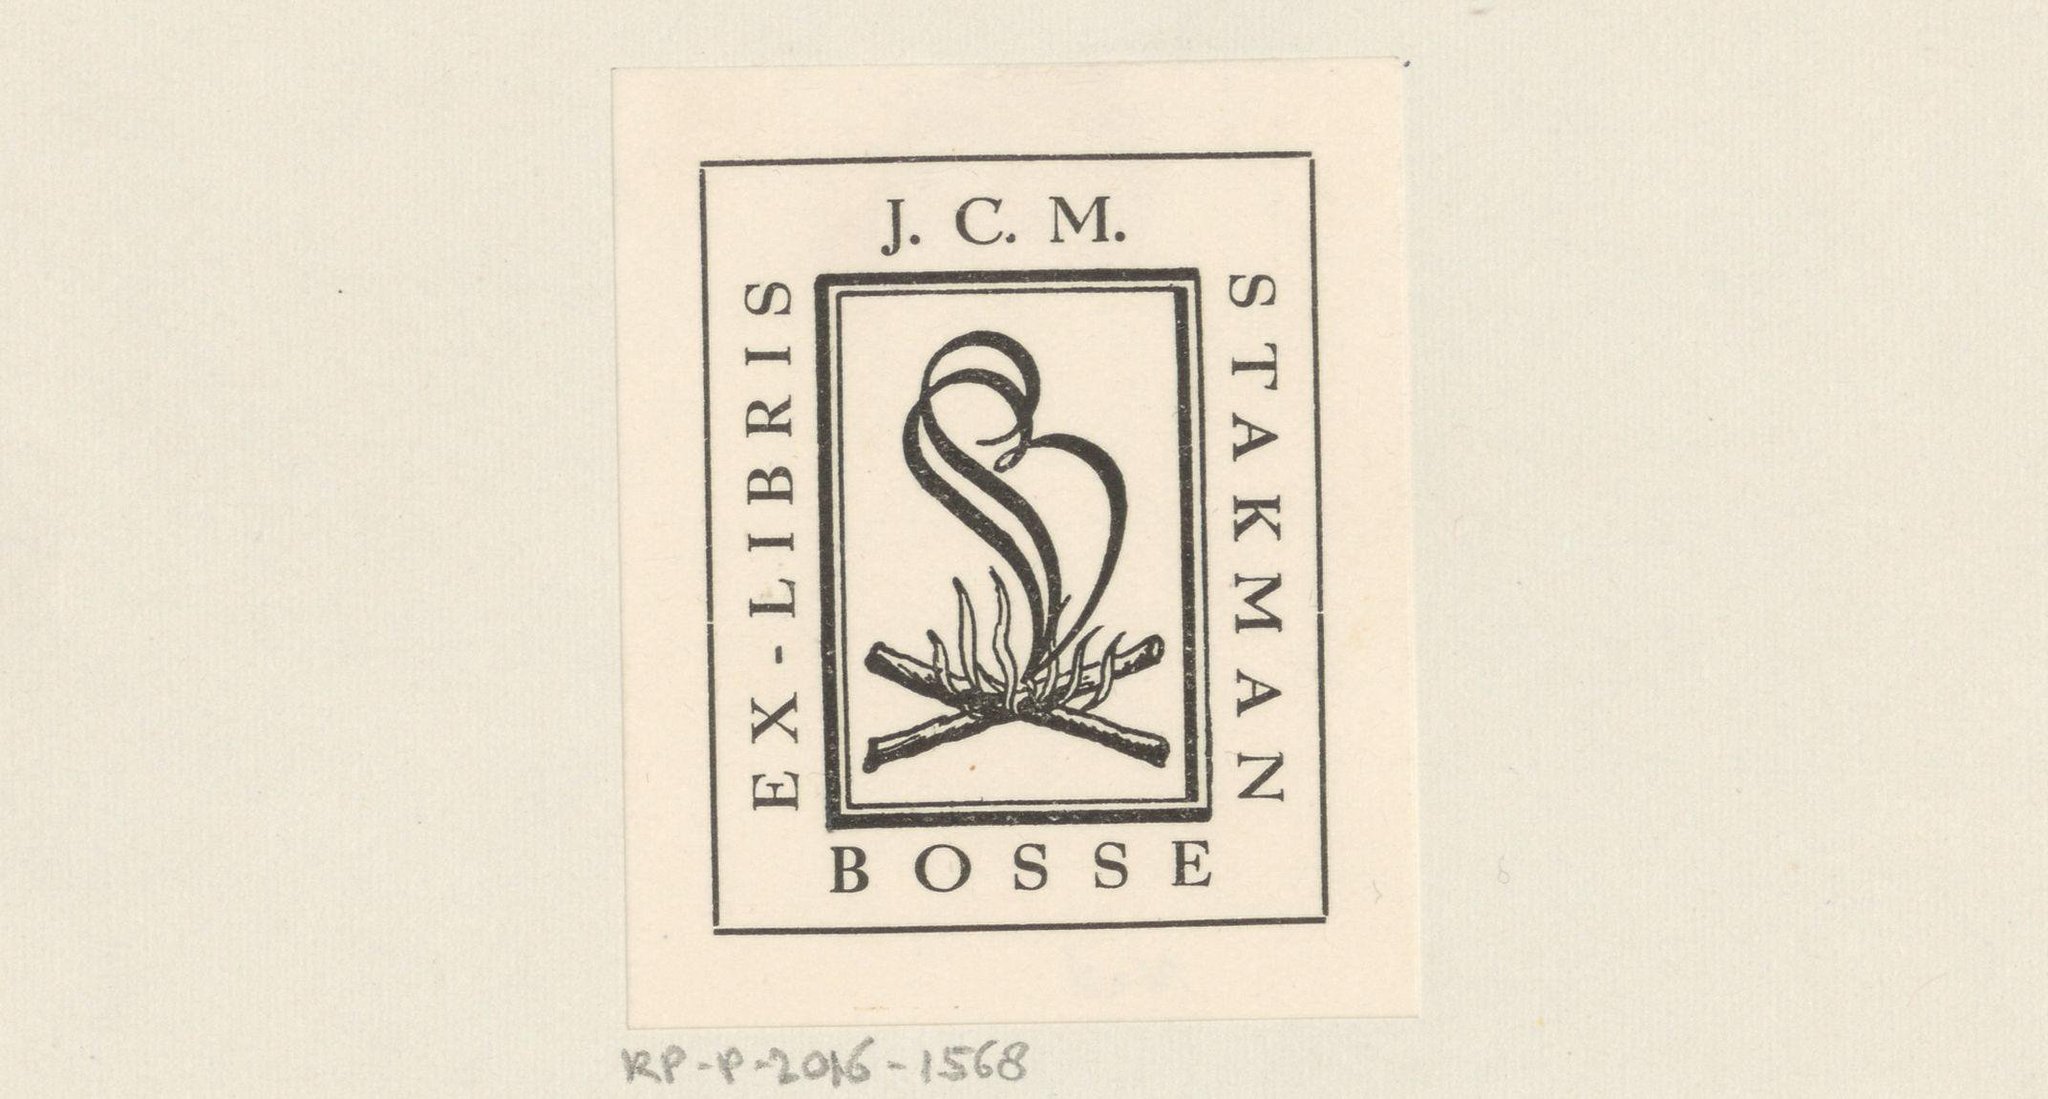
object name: bookplate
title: Ex libris van J.C.M. Stakman Bosse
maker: Anonymous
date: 1900-1999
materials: paper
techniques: printing block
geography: netherlands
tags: bonfire